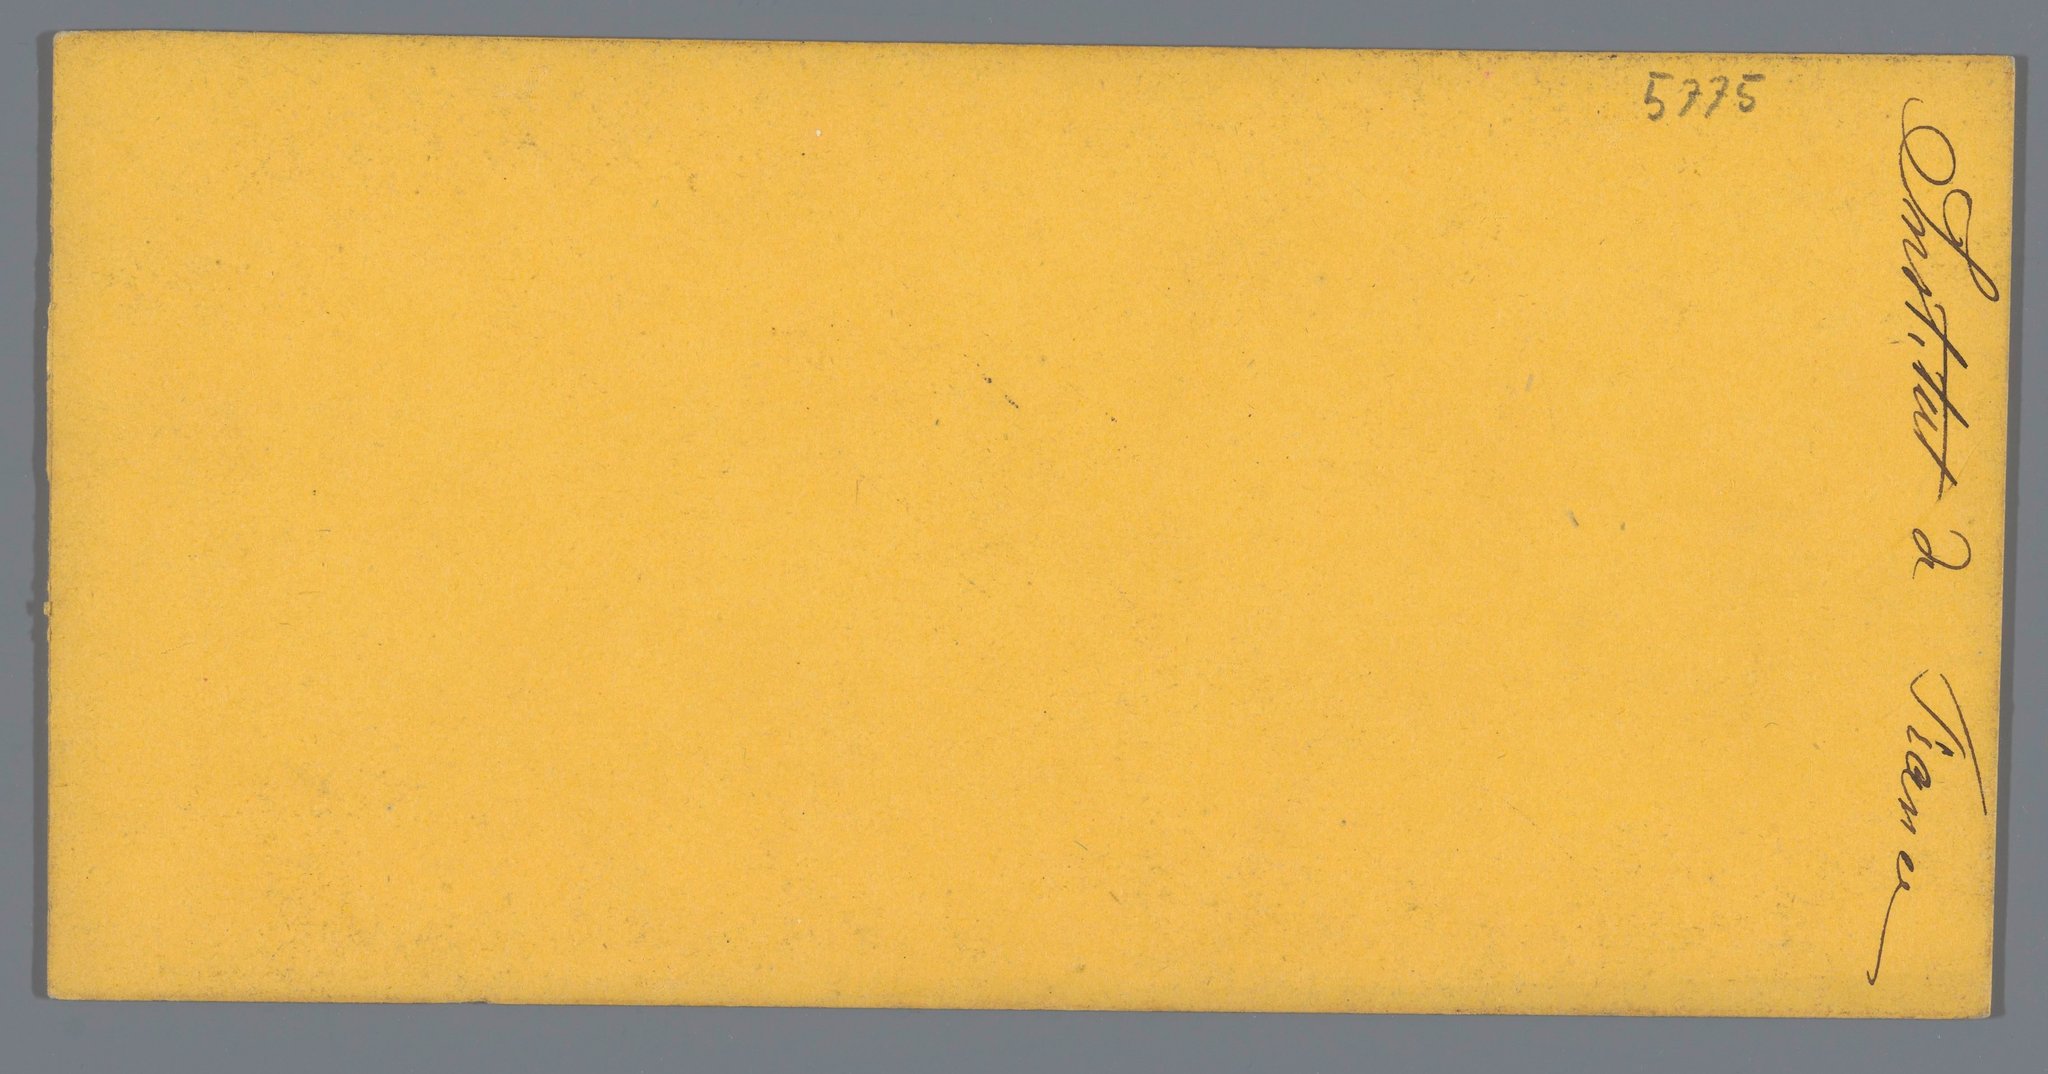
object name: stereograph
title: Gezicht op het Institut de France in Parijs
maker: Anonymous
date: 1850-1880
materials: cardboard, photographic support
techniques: albumen print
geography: paris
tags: bridge in city across river, canal, etc., dome ~ architecture, paris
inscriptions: inscription: ‘Institut de France’